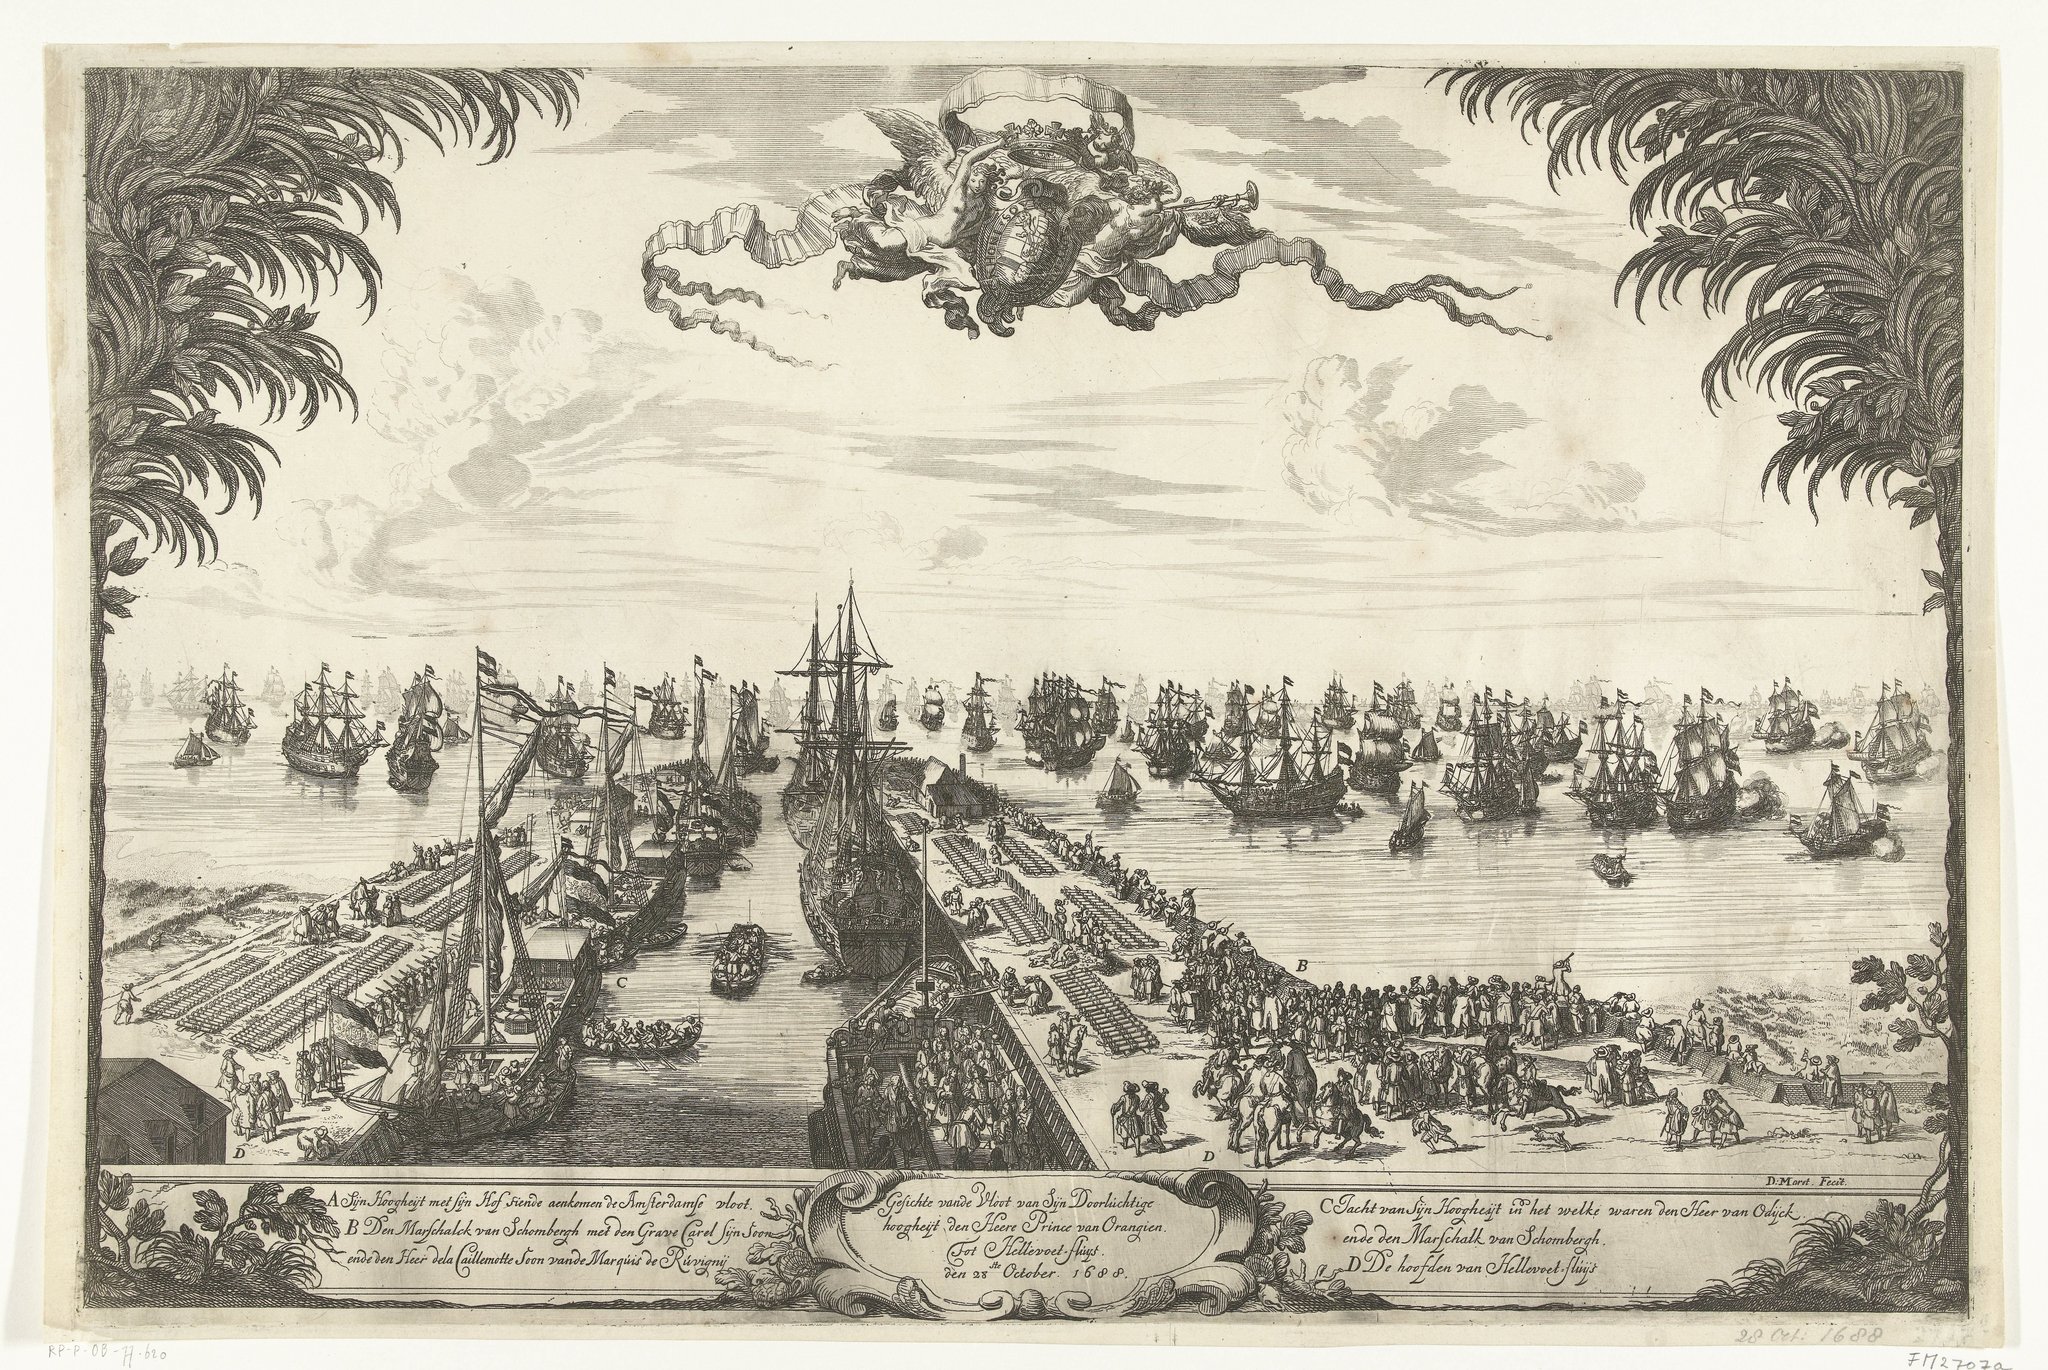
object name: print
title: Gesichte vande Vloot van Sijn Doorluchtige hoogheijt den Heere Prince van Orangien. Tot Hellevoetsluijs. den 28ste October 1688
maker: daniël marot (i)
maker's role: draughtsman, print maker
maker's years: 1661-1752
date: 1688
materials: paper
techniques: etching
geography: northern netherlands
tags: the hague, william iii (prince of orange and king of england, scotland, and ireland), traffic and transport (+ loading), firearms: cannon, pier, quay, wharf, hellevoetsluis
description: De vloot wordt in de haven van Hellevoetsluis in gereedheid gebracht voor de tocht van prins Willem III met zijn leger naar Engeland, 28 oktober 1688. Een panormabeeld van de vloot van Stadhouder Willem III, met een uitleg in een kader onderin (waar ook de titel), links en rechts een halve palmboom en een gekroond schild met bazuinengelen boven. De vloot lijkt grotendeels klaar te liggen op zee, maar enkele schepen worden nog geladen met kanonnen die klaar liggen op de kade. Linksvooraan ligt een schip dat gemarkeerd is (met een C) als het schip van 'sijn Hoogheijt in het welk waren den Heer van Odijck ende den Marschalk van Schombergh'. De laatste vinden we rechts aan de kade (gemarkeerd met een B) waar hij de vloot schouwt in gezelschap van de 'den Grave Carel sijn soon ende den Heer dela Caillemotte Soon vande Marquis de Ruvignij '. Links en rechts palmbomen, in de lucht engelen met het wapen van de prins.